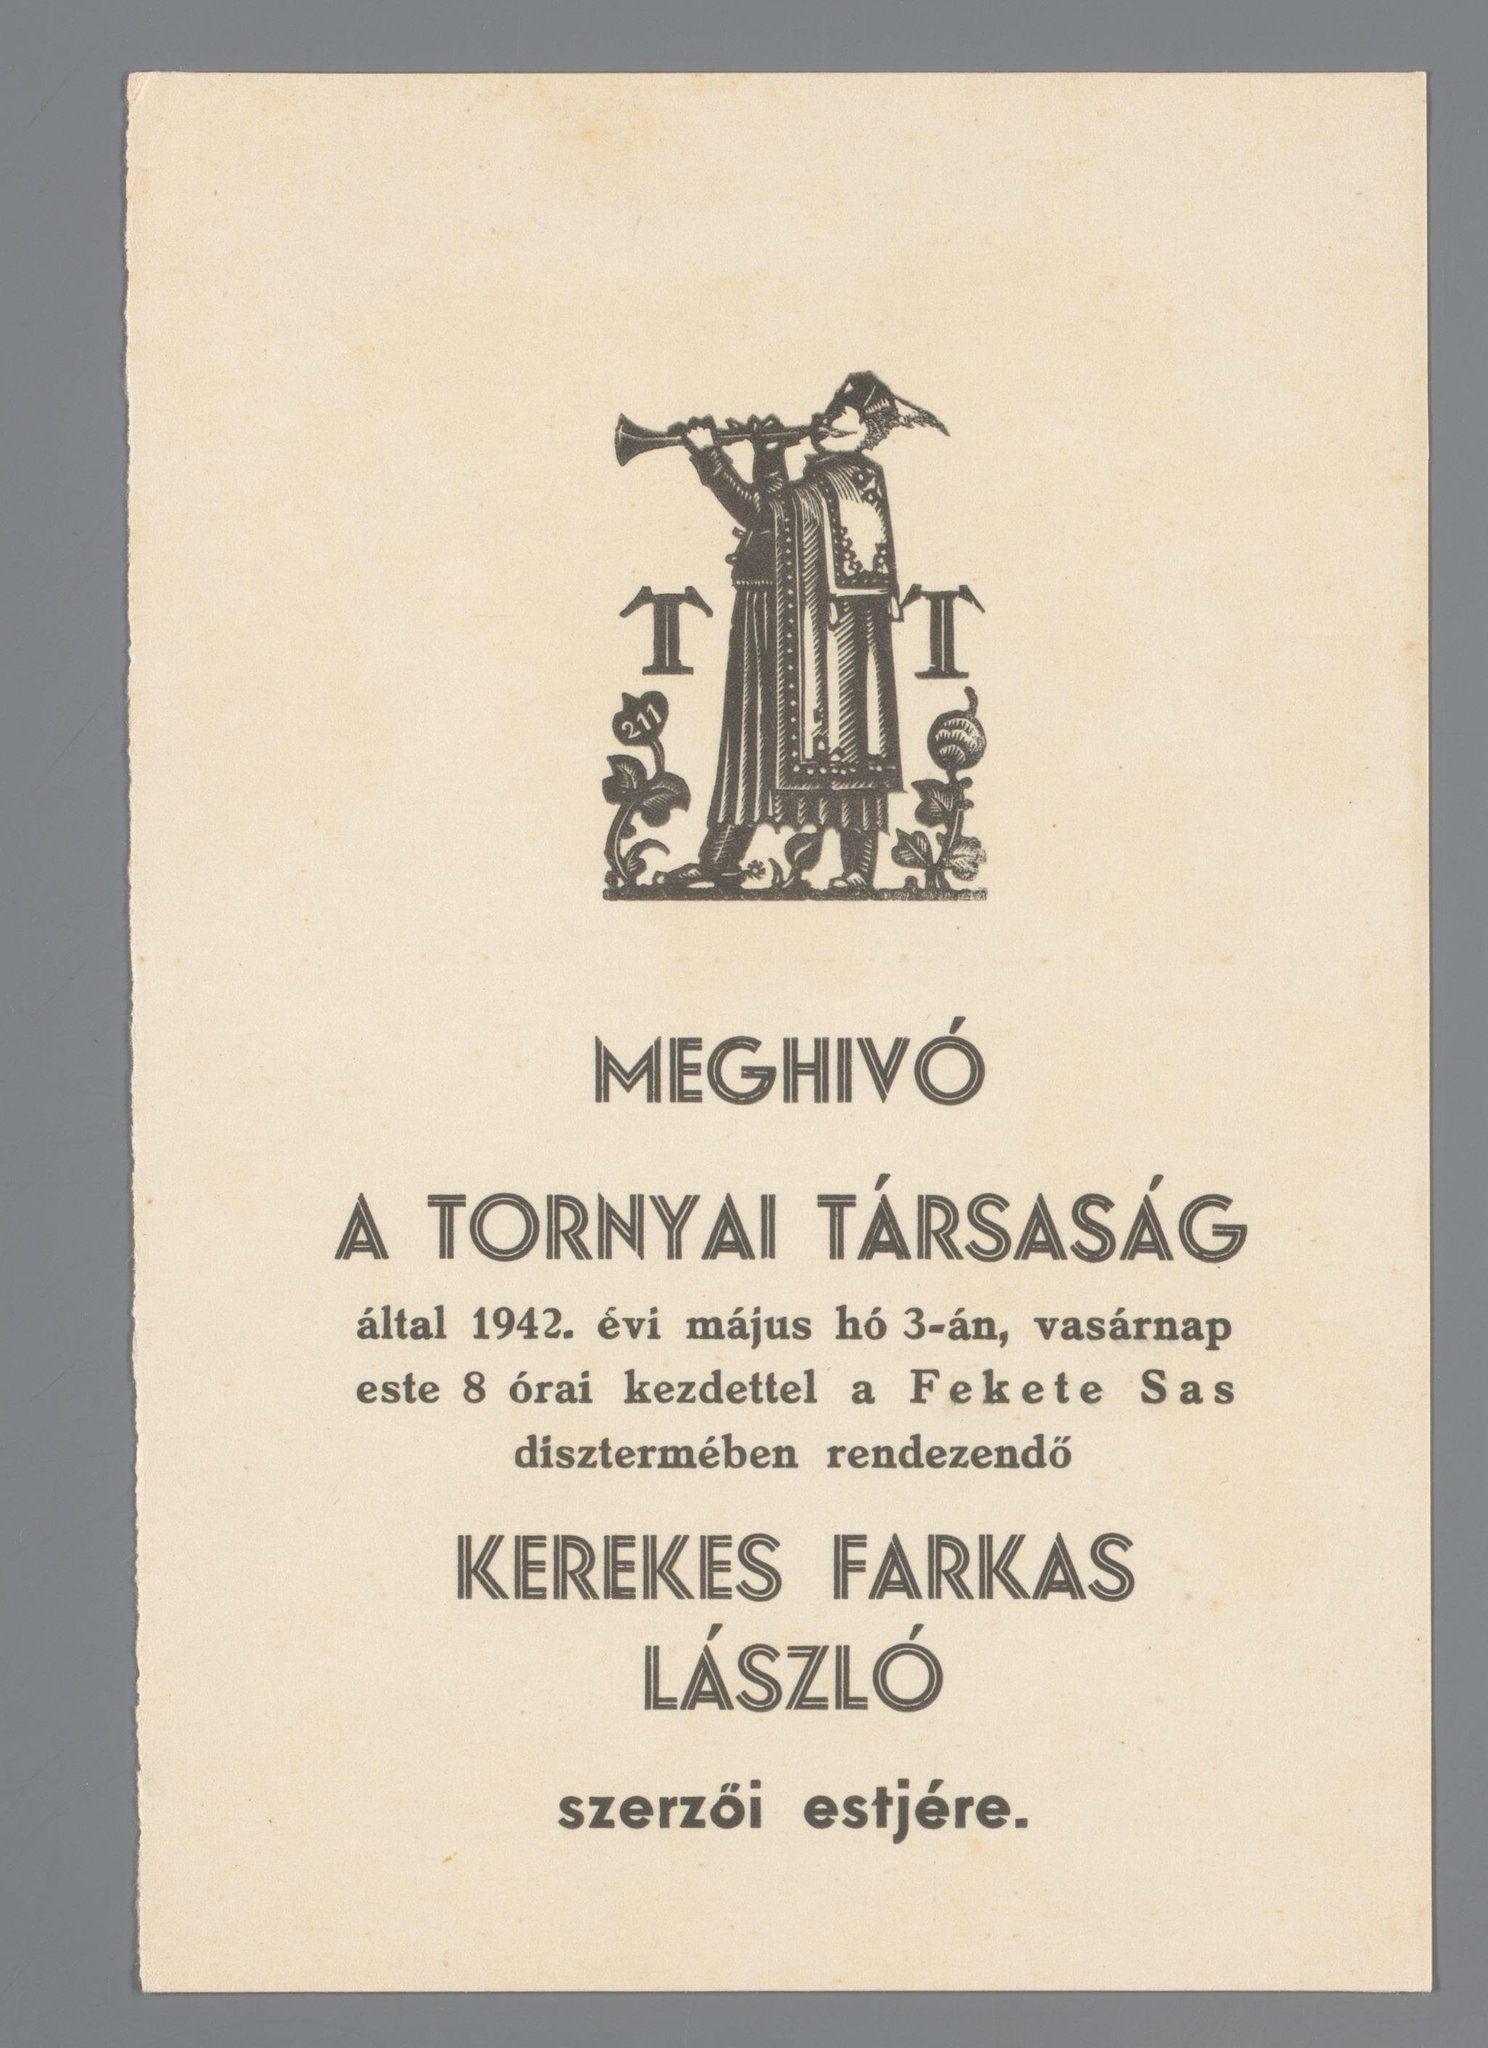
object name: invitation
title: Uitnodiging voor een uitvoering van László Kerekes Farkas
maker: Anonymous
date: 1942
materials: paper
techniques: letterpress printing, engraving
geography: hungary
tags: lászló kerekes farkas, wind instruments, folk costume, regional costume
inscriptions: date